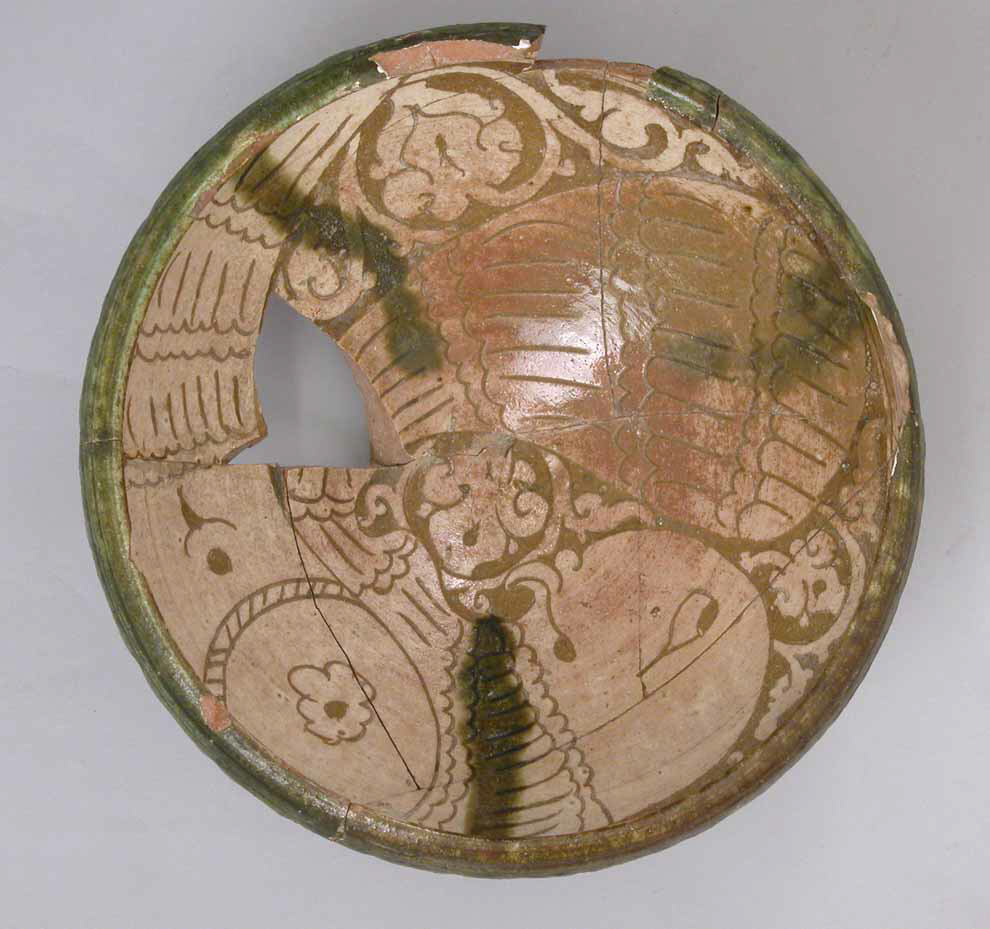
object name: bowl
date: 1101-1200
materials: earthenware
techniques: carving, glazing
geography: syria